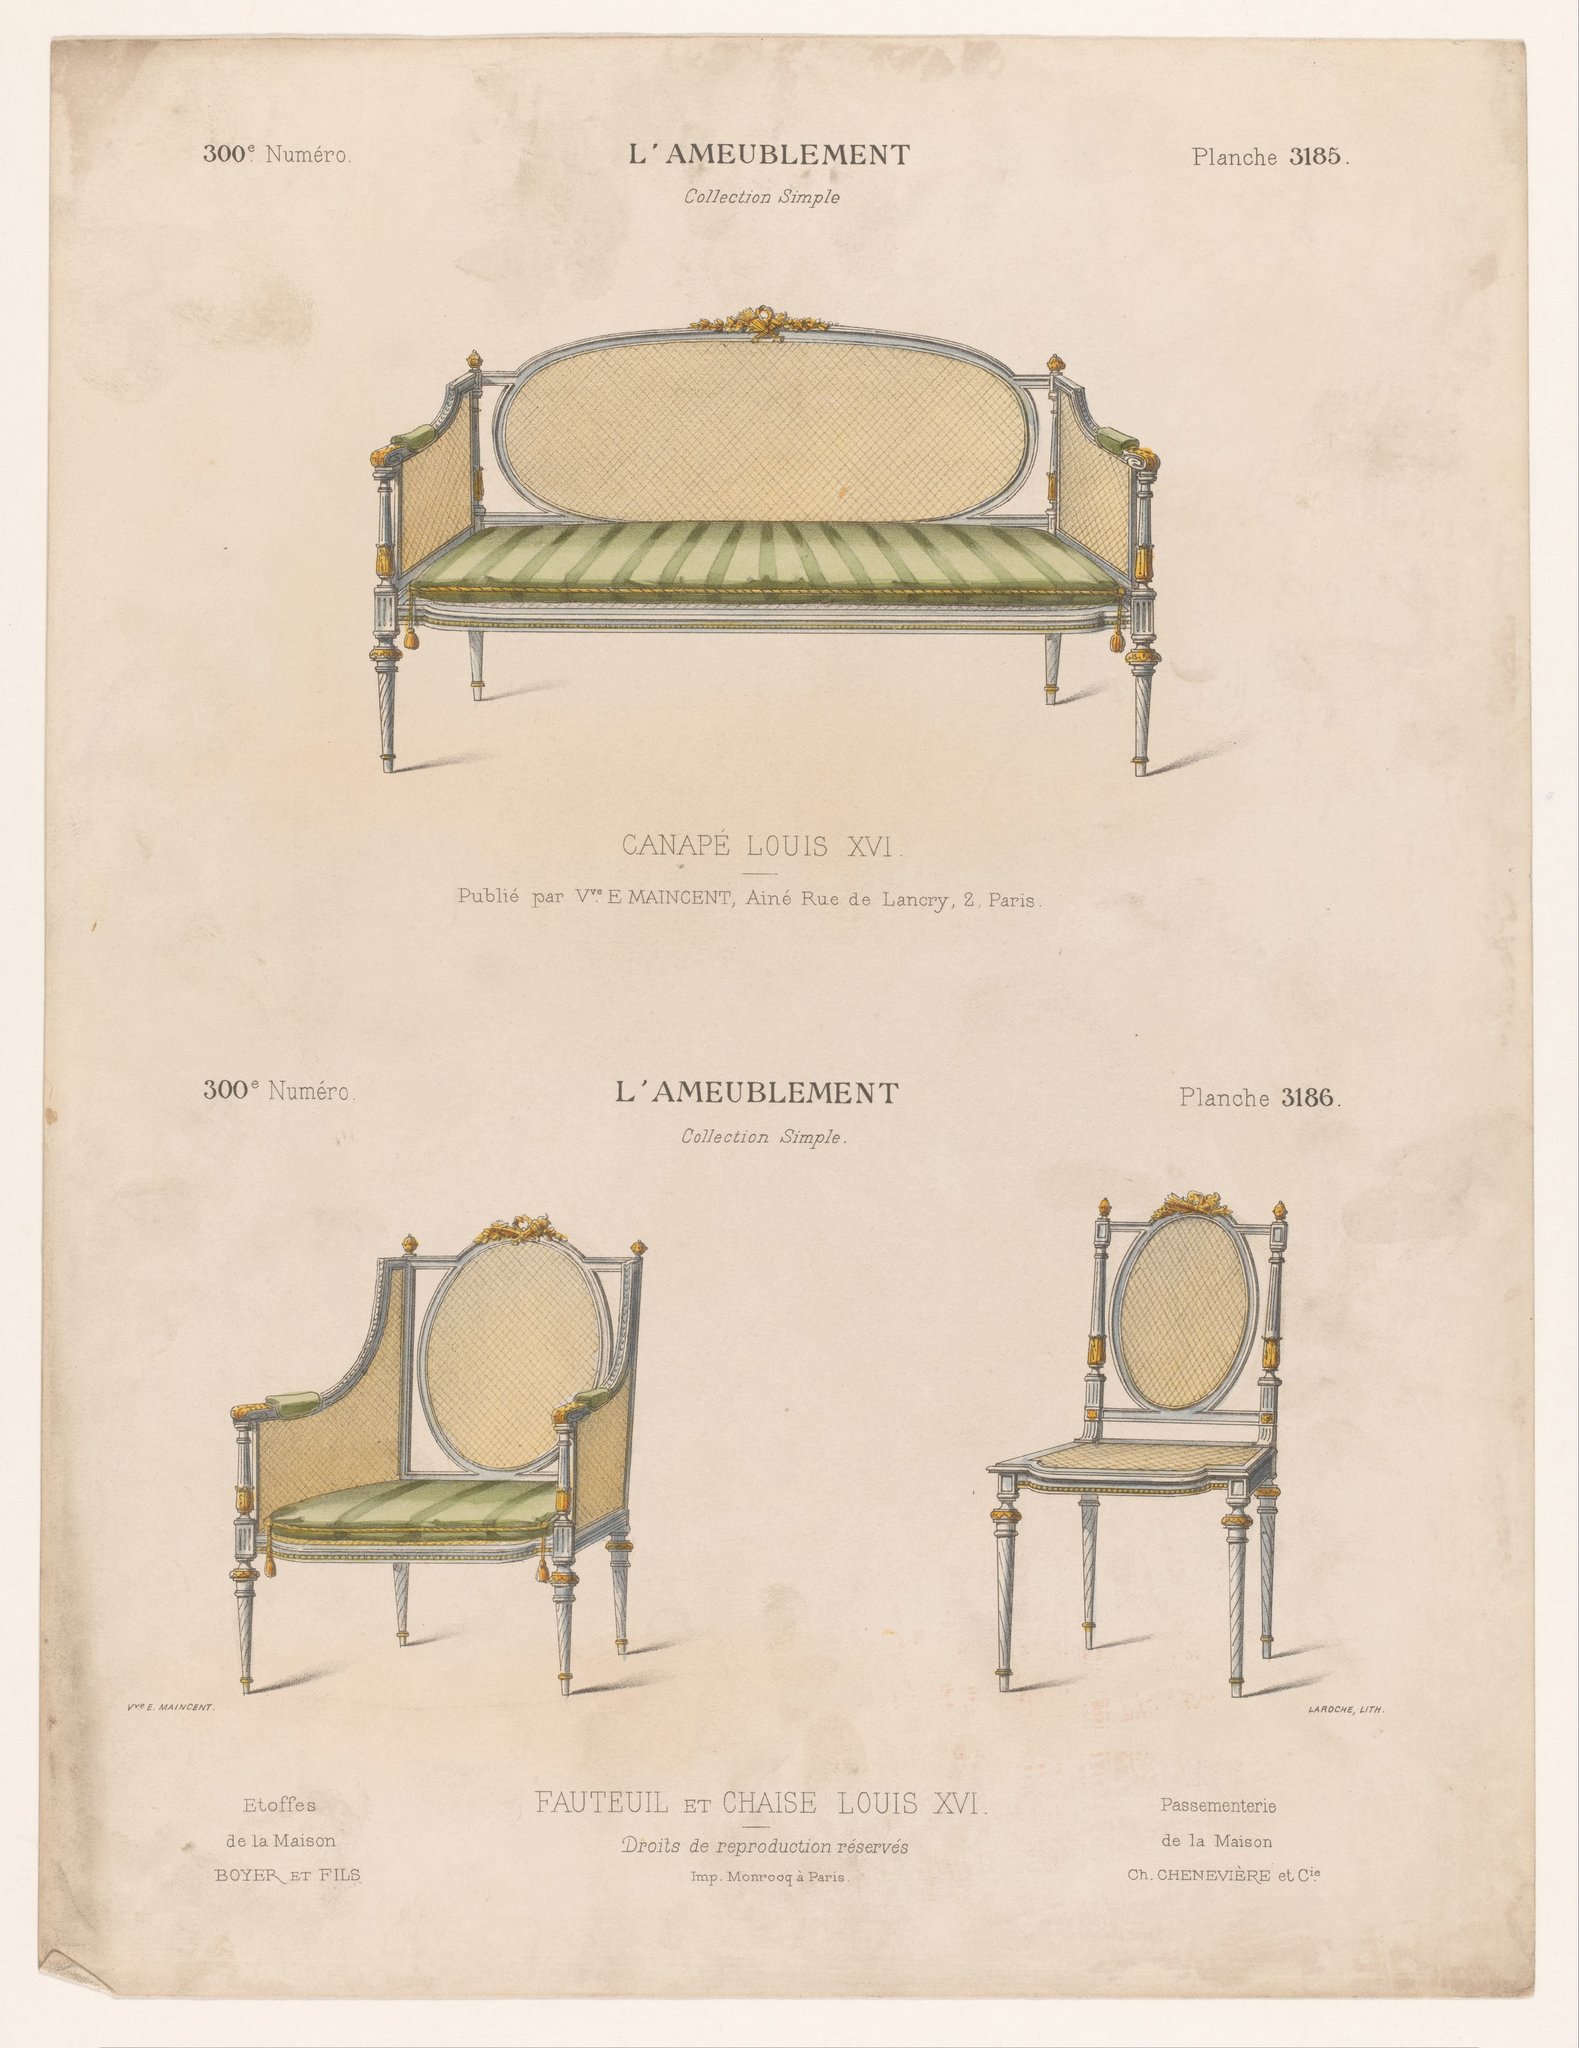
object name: print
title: Canapé, fauteuil en stoel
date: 1895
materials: paper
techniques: hand coloring, lithograph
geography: paris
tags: seating furniture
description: Een canapé, fauteuil en een stoel in de Lodewijk XVI-stijl. Prent uit 300e nummer (livraison).